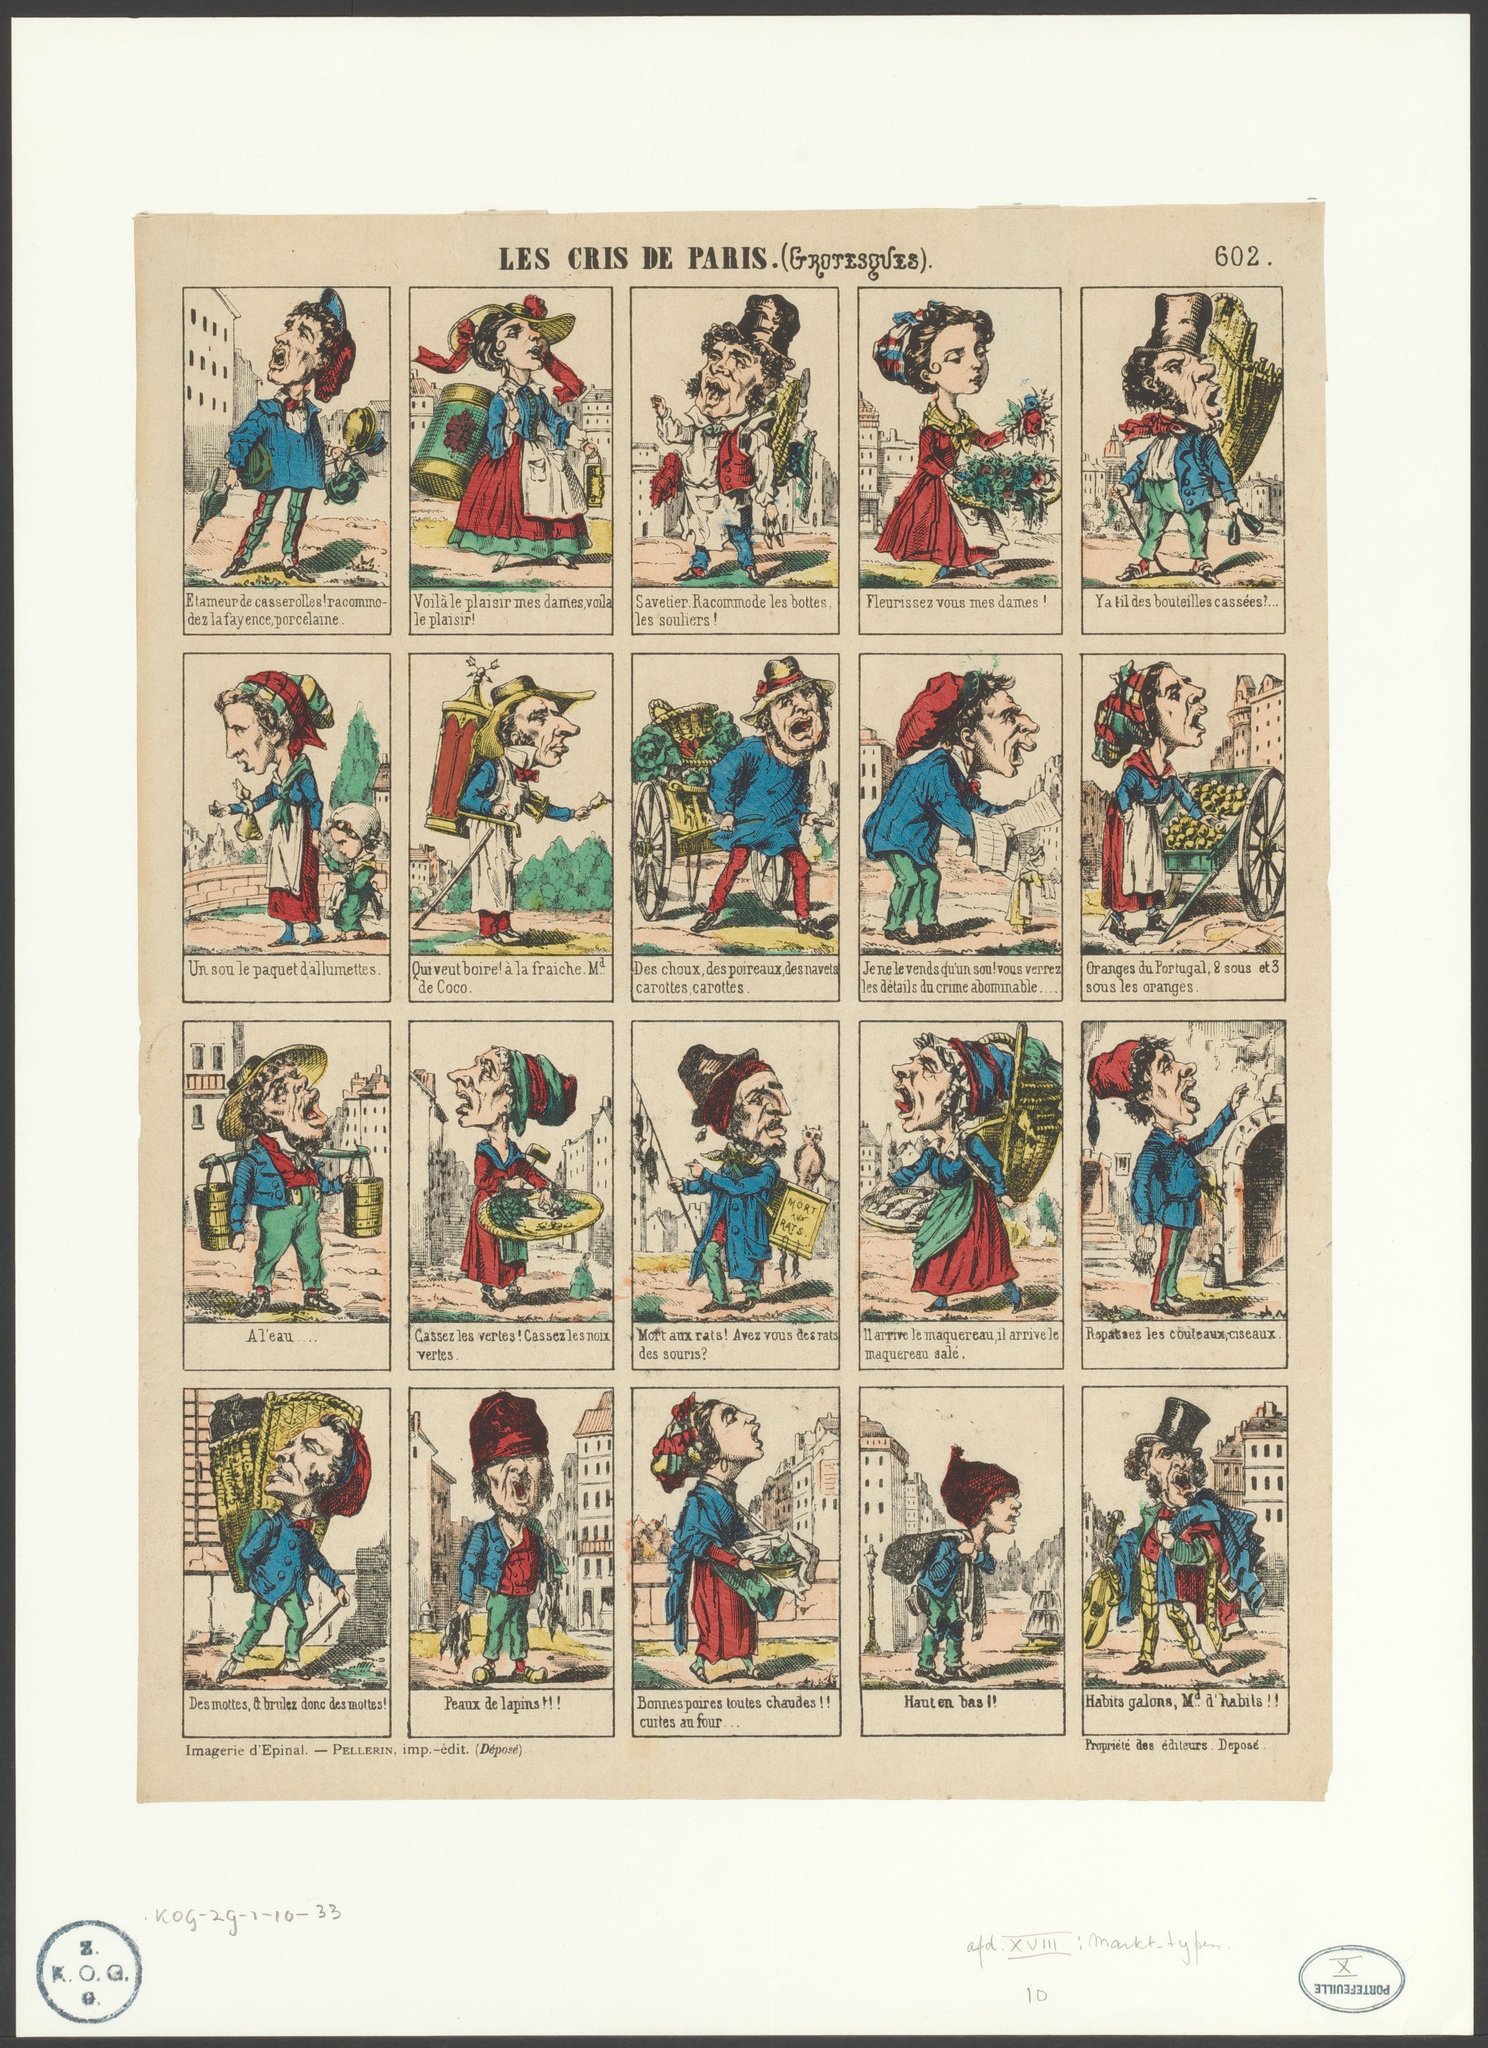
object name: print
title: Marktverkopers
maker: Anonymous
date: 1800-1899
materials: paper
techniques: hand coloring, lithograph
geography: epinal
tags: caricatures (human types), street-trader, merchant, salesman, 'cris de paris', cries of london, etc., 'cris de paris', cries of london, etc. - bb - women engaged in trade and commerce, paris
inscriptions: collector's mark: Lugt 1641, stamp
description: Blad met twintig voorstellingen van straatverkopers, zoals een fruitverkoopster, een rattengifverkoper en een visverkoopster. Onder elke voorstelling een tweeregelig tekst in het Frans, met de uitroepen van marktverkopers in Parijs. Genummerd rechtsboven: 602. Onderwerpsrubrieken binnen de Atlas Zeden en Gewoonten: Handel, nijverheid en verkeer, Marktwezen, Markttafereelen, Marktfiguren.